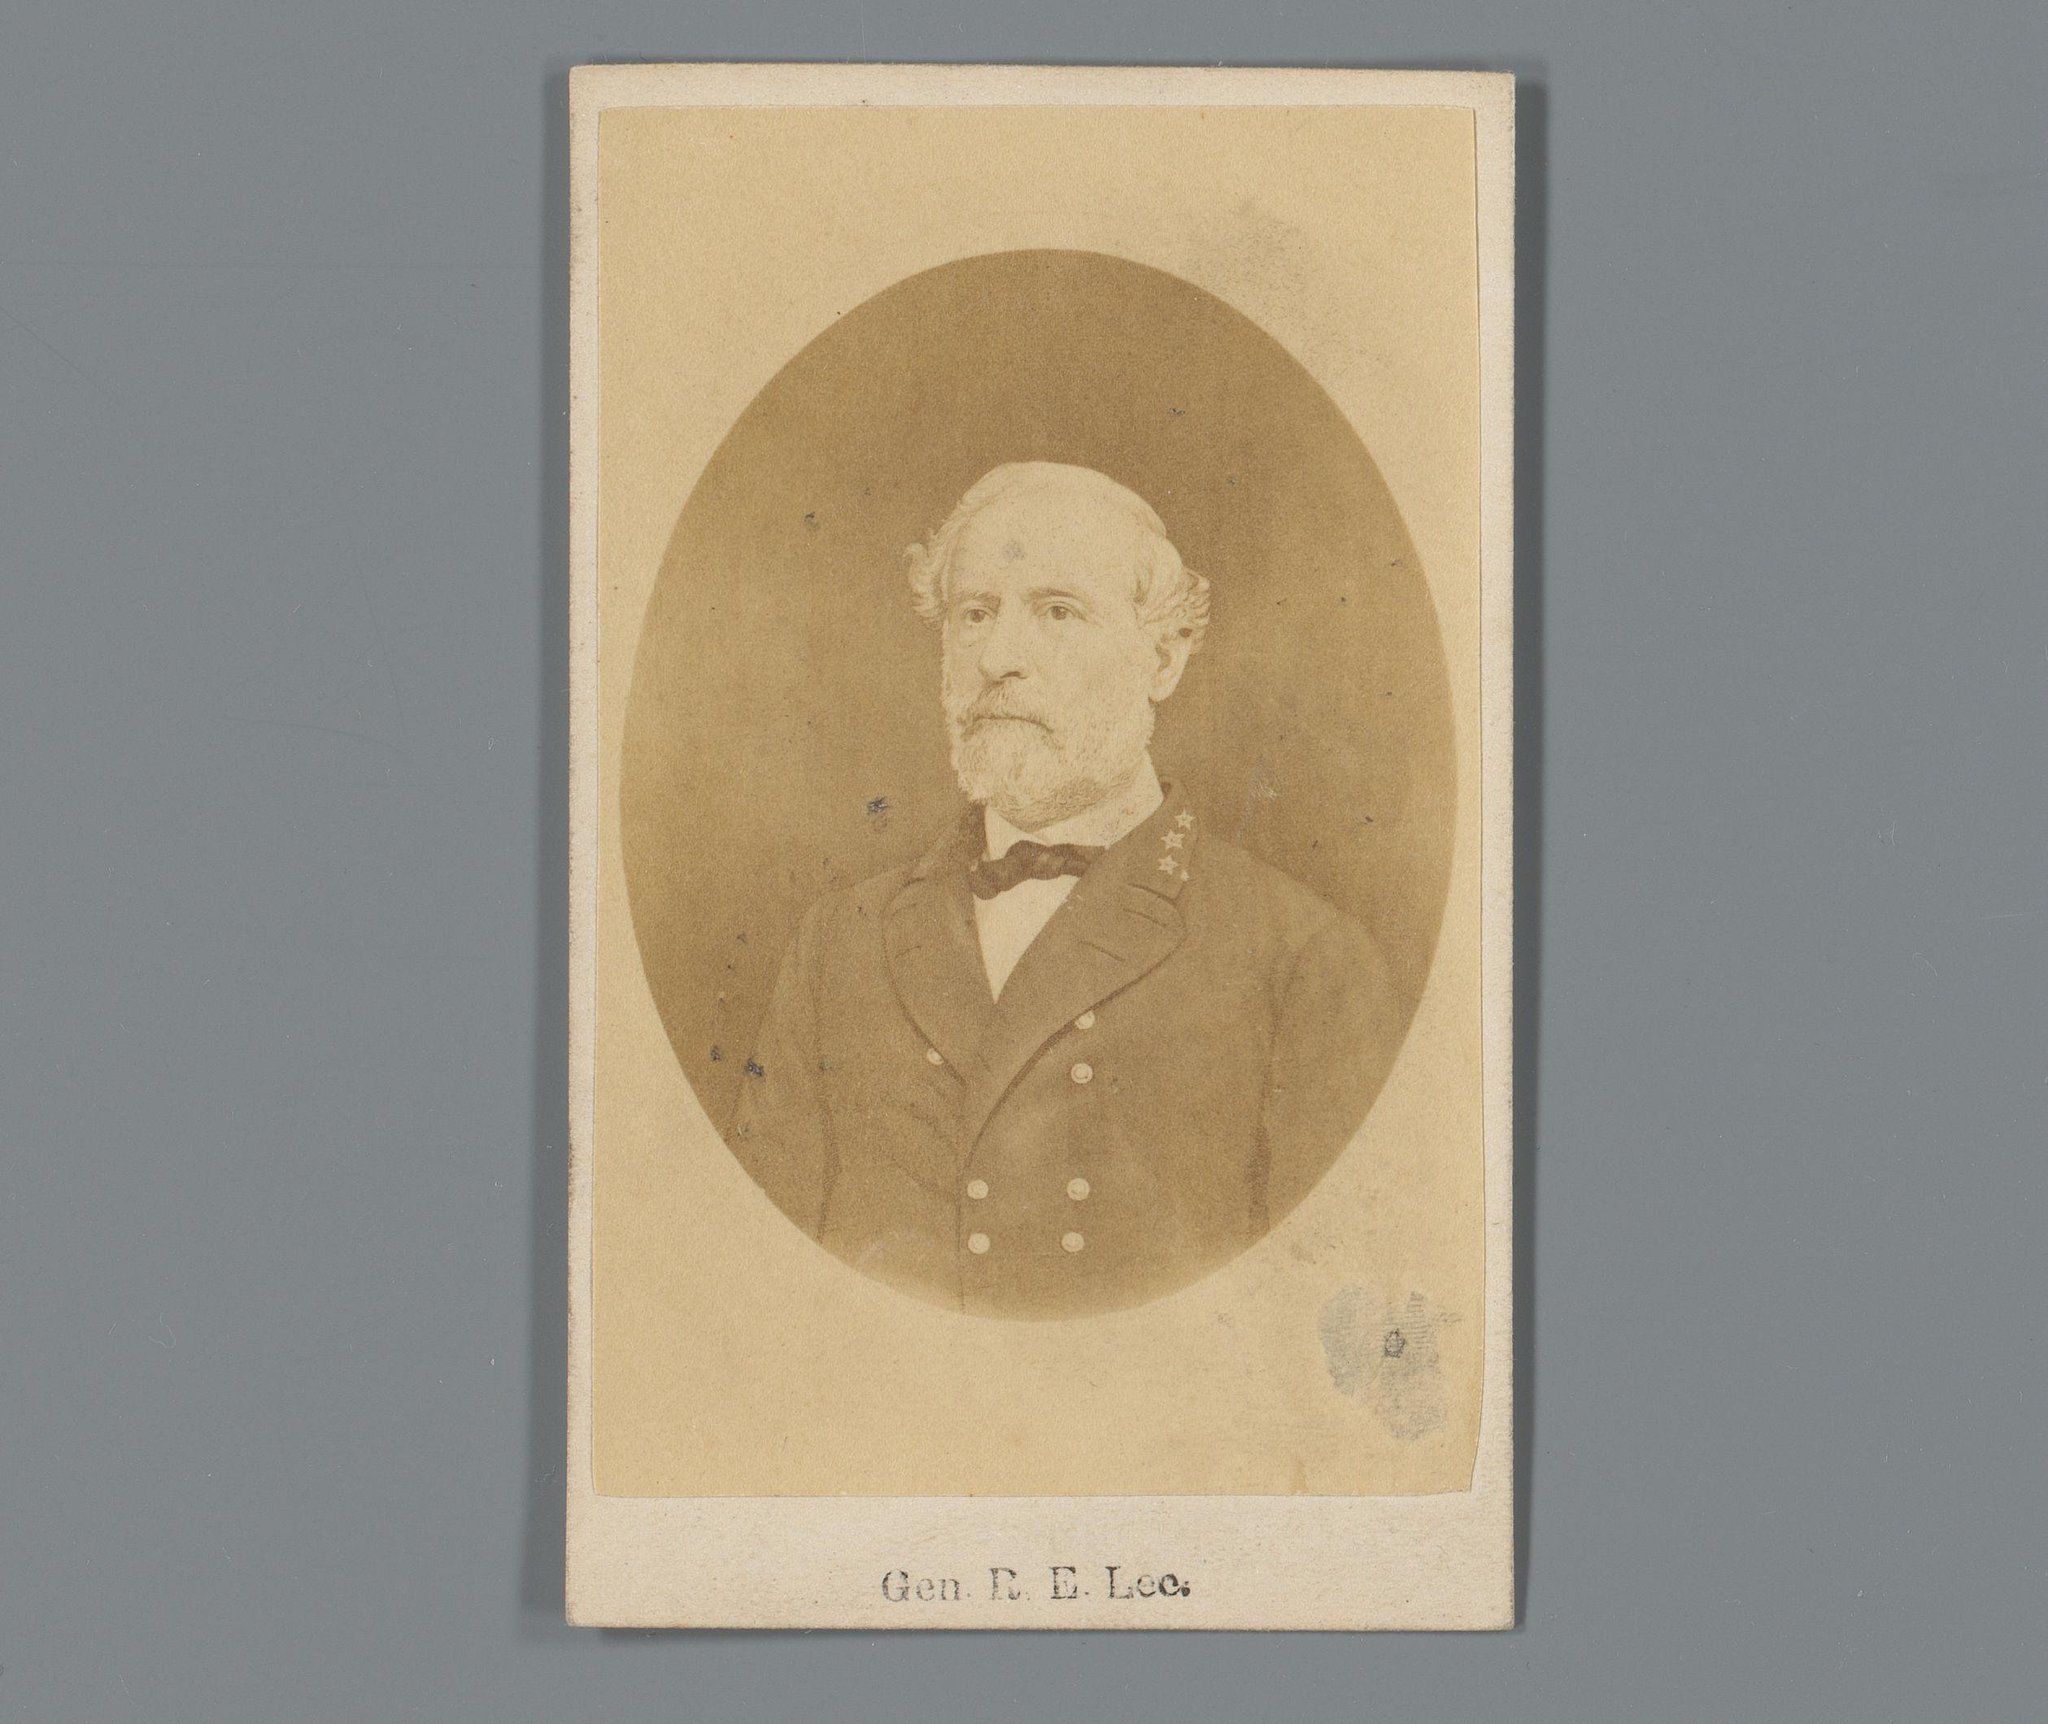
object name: photograph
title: Portret van Robert E. Lee met reclame voor een warenhuis van B. Green in Chicago, Illinois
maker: Anonymous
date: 1850-1915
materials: cardboard, photographic support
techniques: albumen print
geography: chicago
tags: advertising, historical persons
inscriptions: inscription: ‘B. GREEN'S/ Modern Wonder/ DEPARTMENT/ DOLLAR SALE./ Please examine our goods which we sell you/ for One Dollar in Department 3/ 172 East Madison Street, CHICAGO, ILL.’